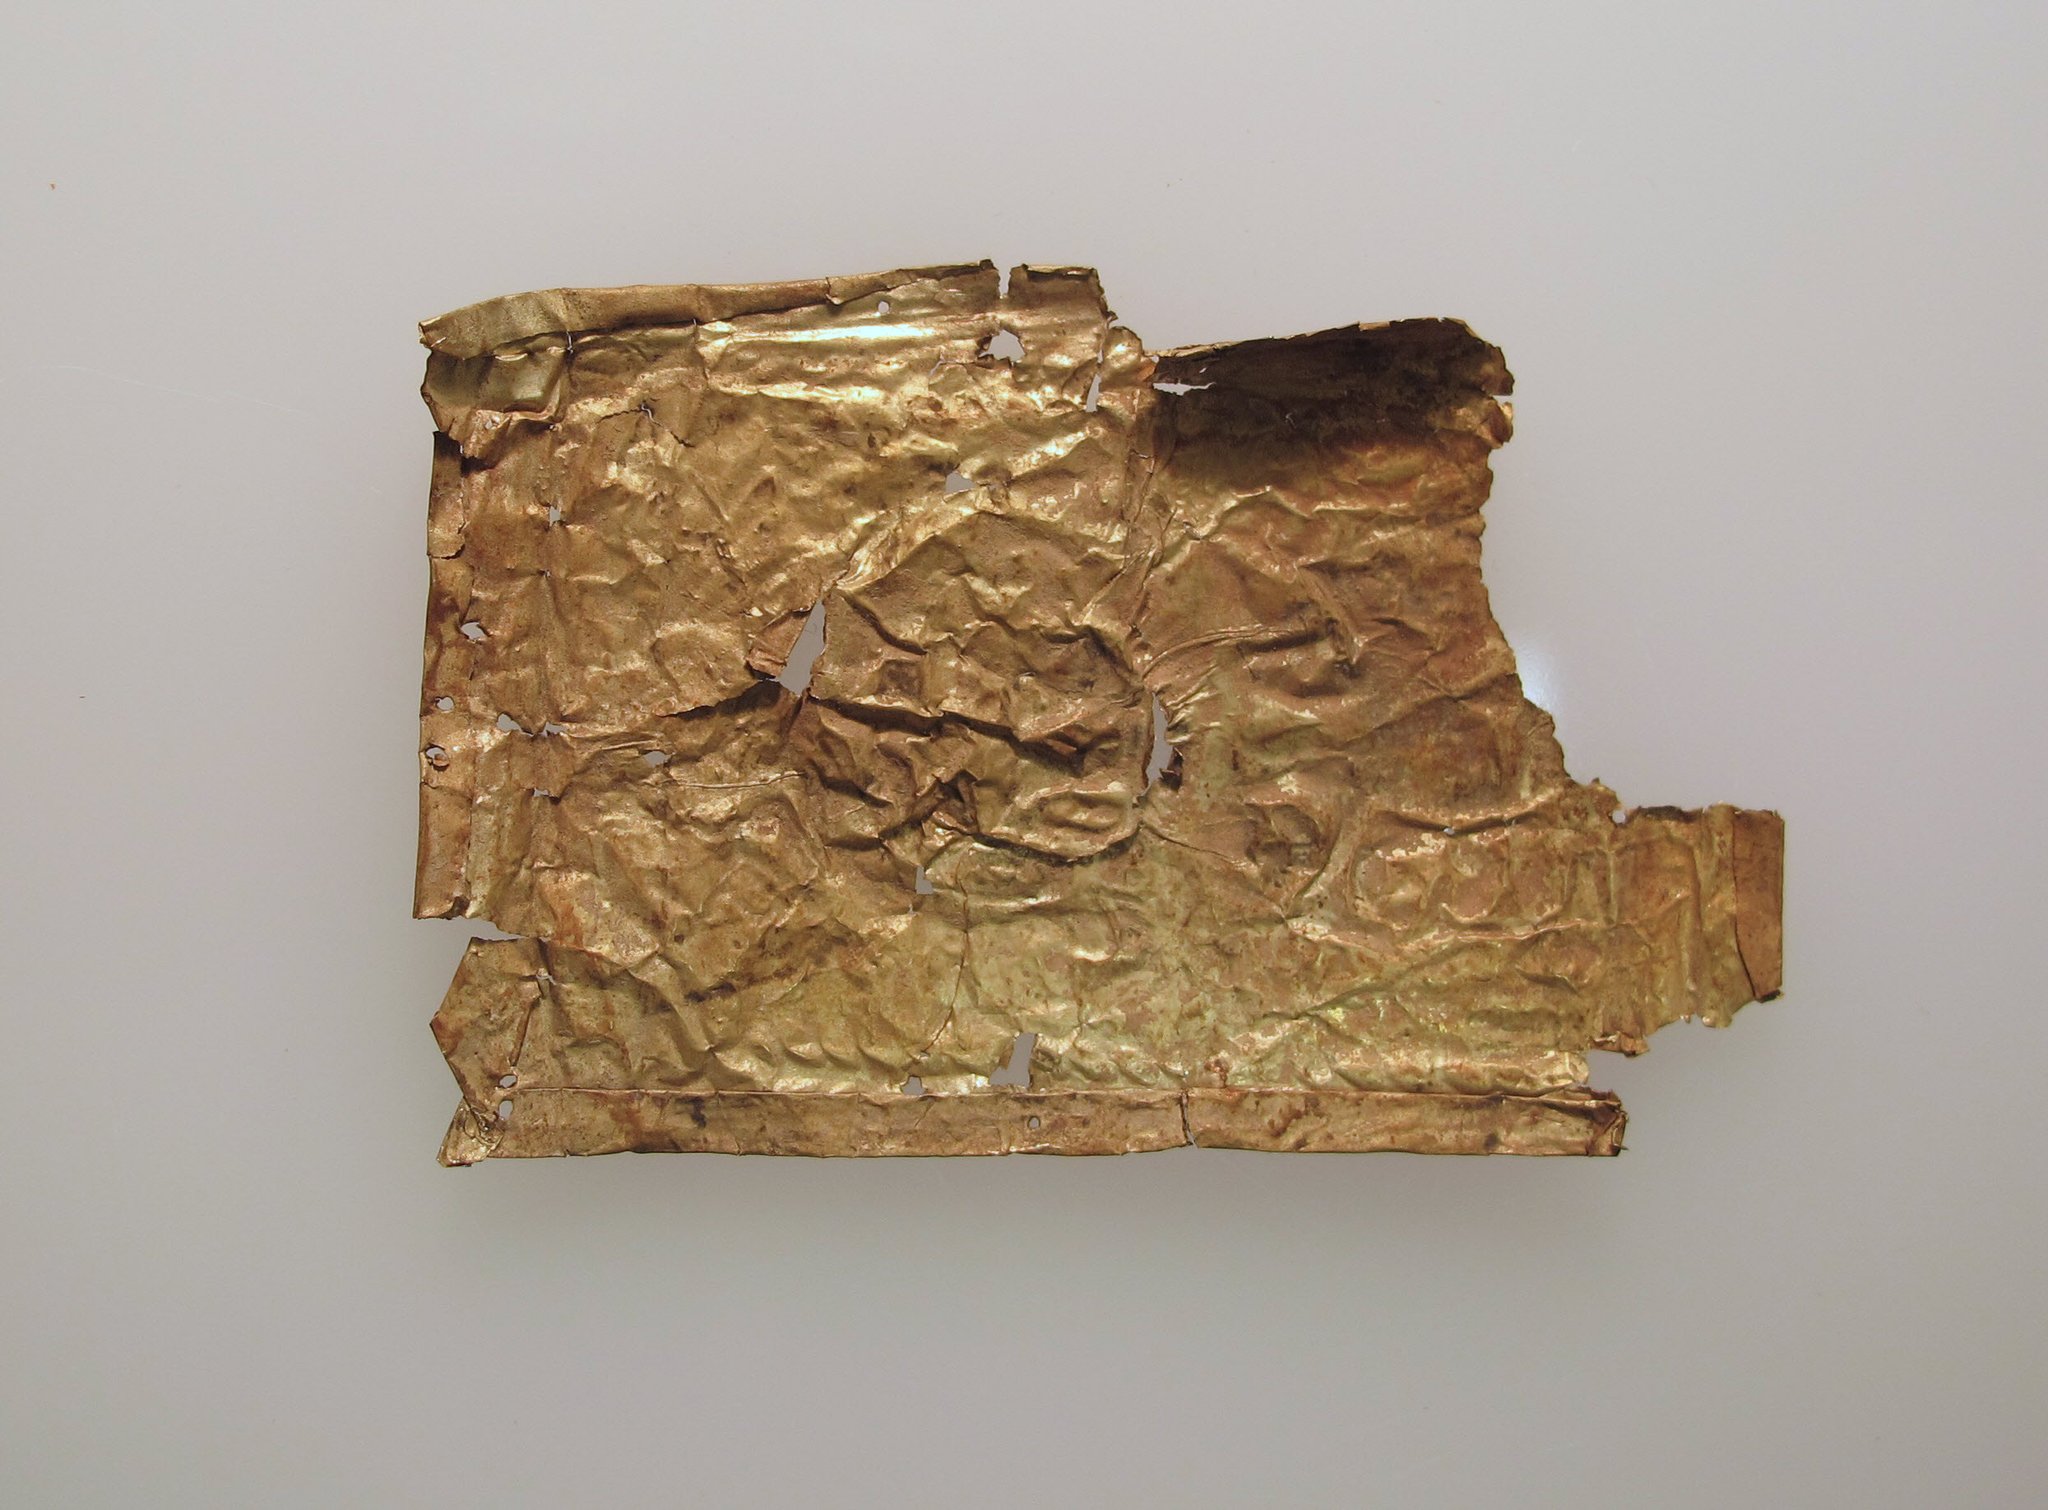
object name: plaque, thin gold leaf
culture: cypriot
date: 3900 BCE-100 CE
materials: gold